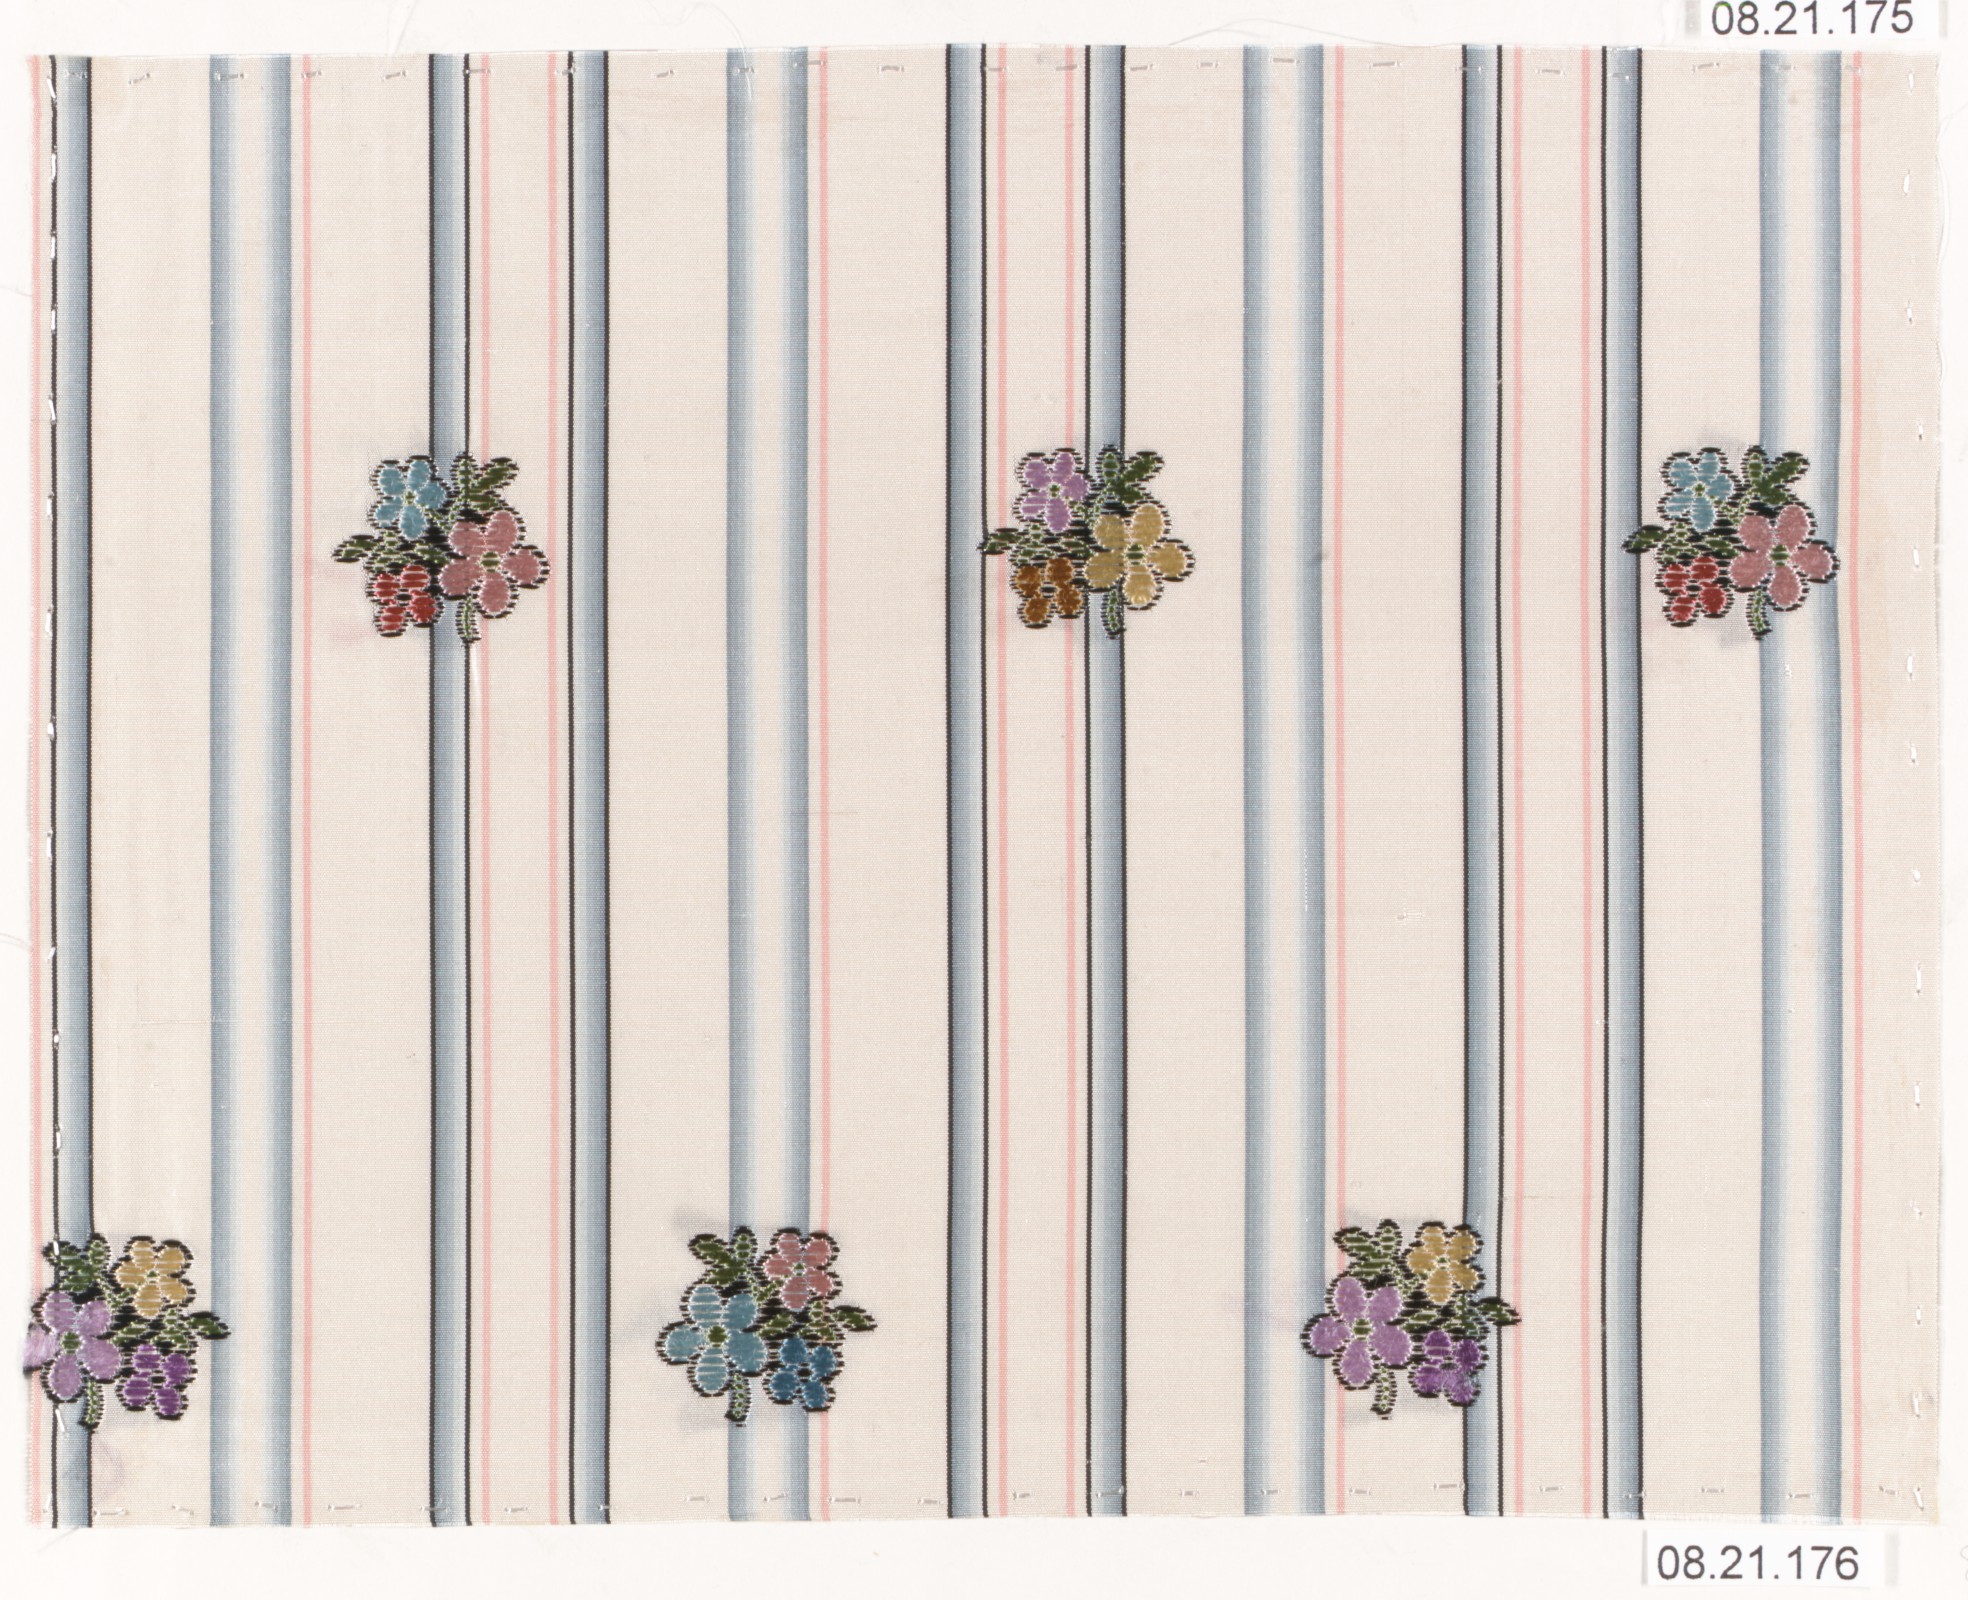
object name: textile sample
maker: Anonymous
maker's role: designer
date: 1900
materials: silk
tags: flowers